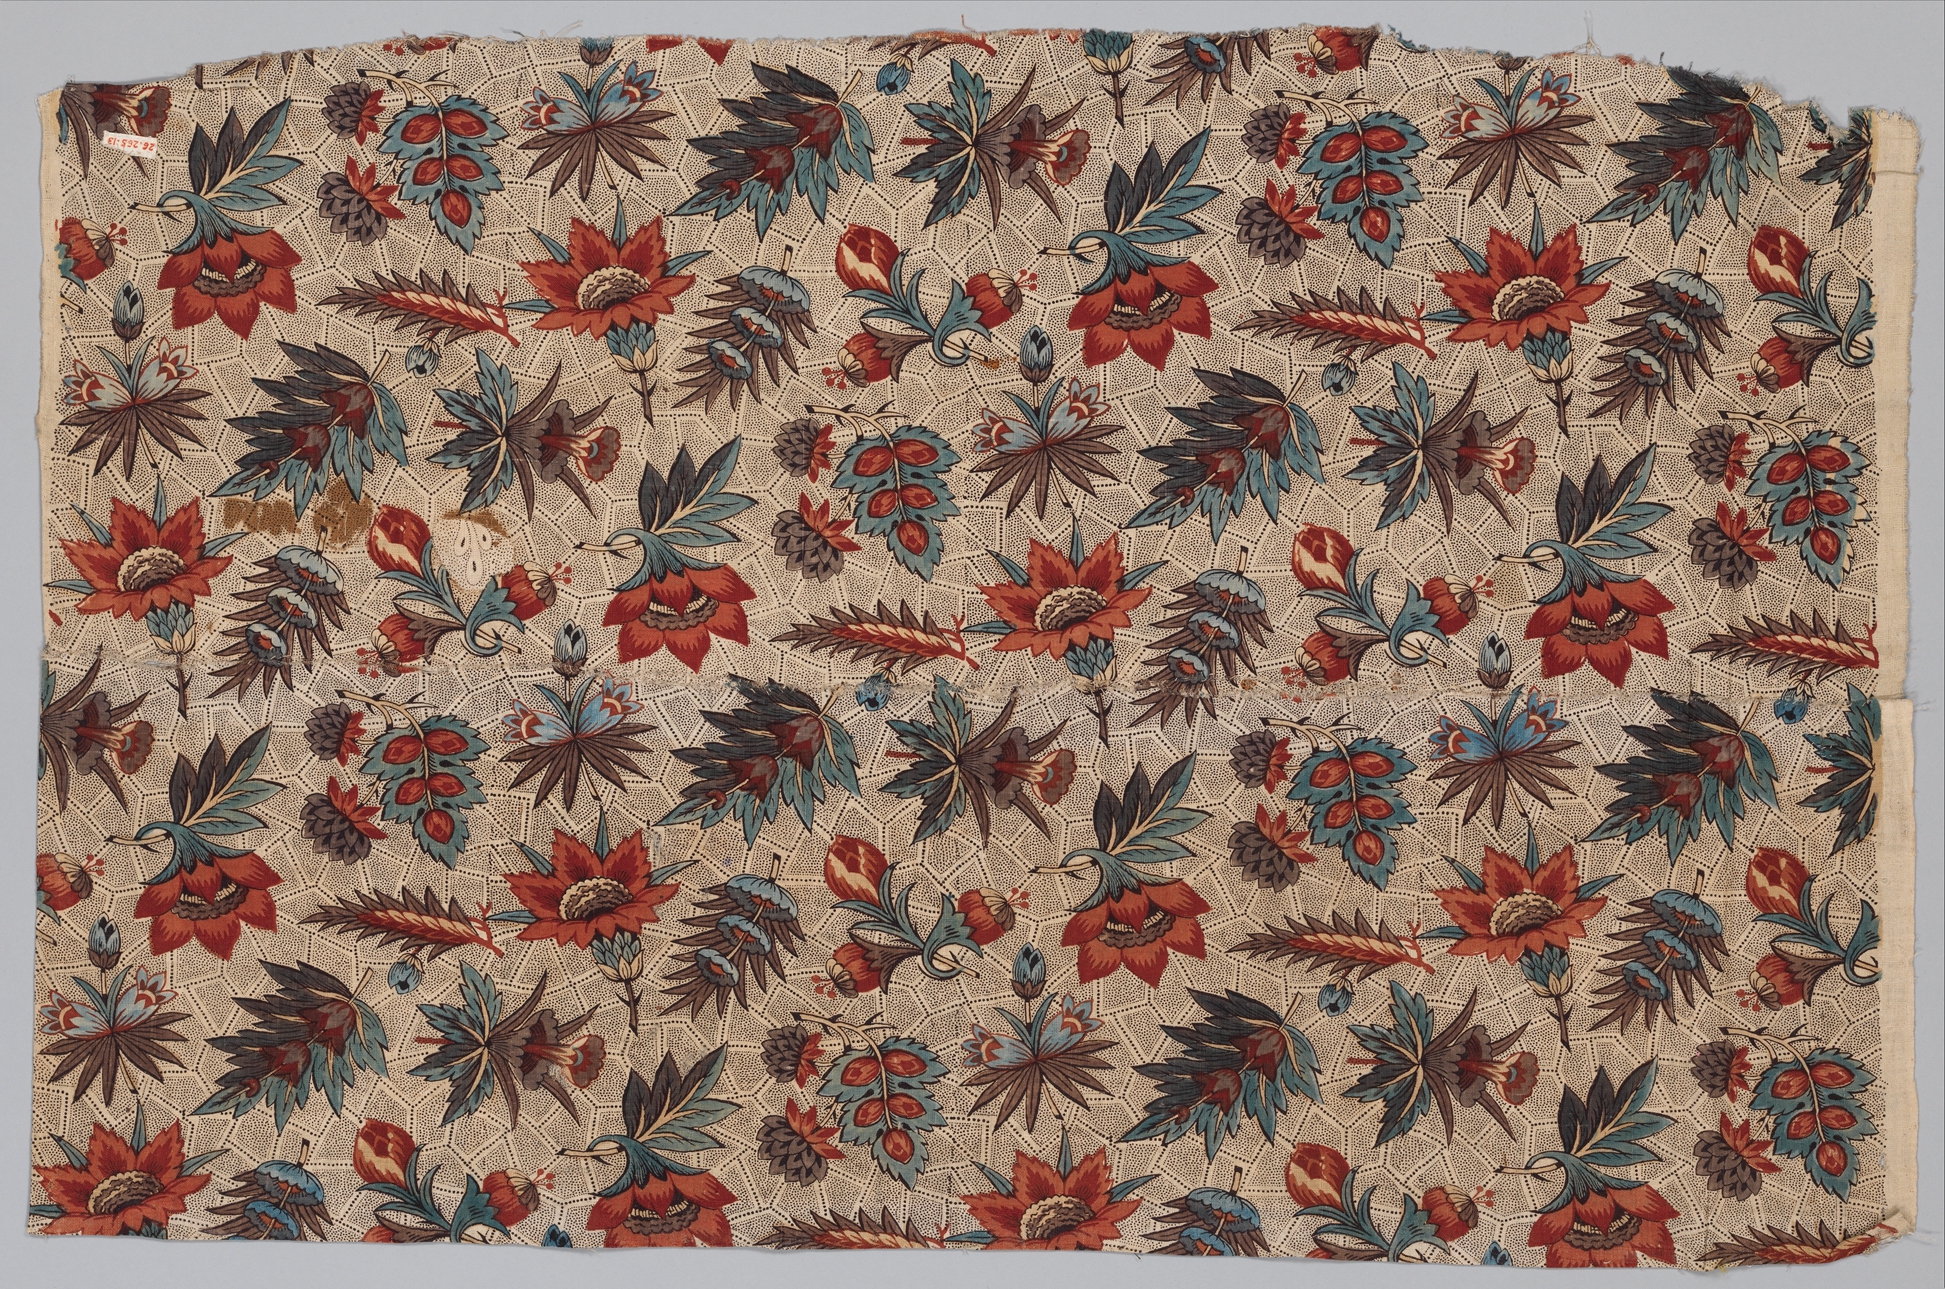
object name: piece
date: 1767-1800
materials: cotton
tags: flowers,leaves